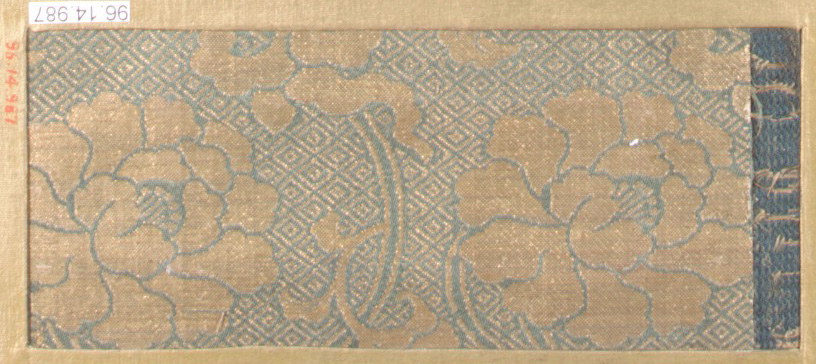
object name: piece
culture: japanese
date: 1701-1900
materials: silk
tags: flowers